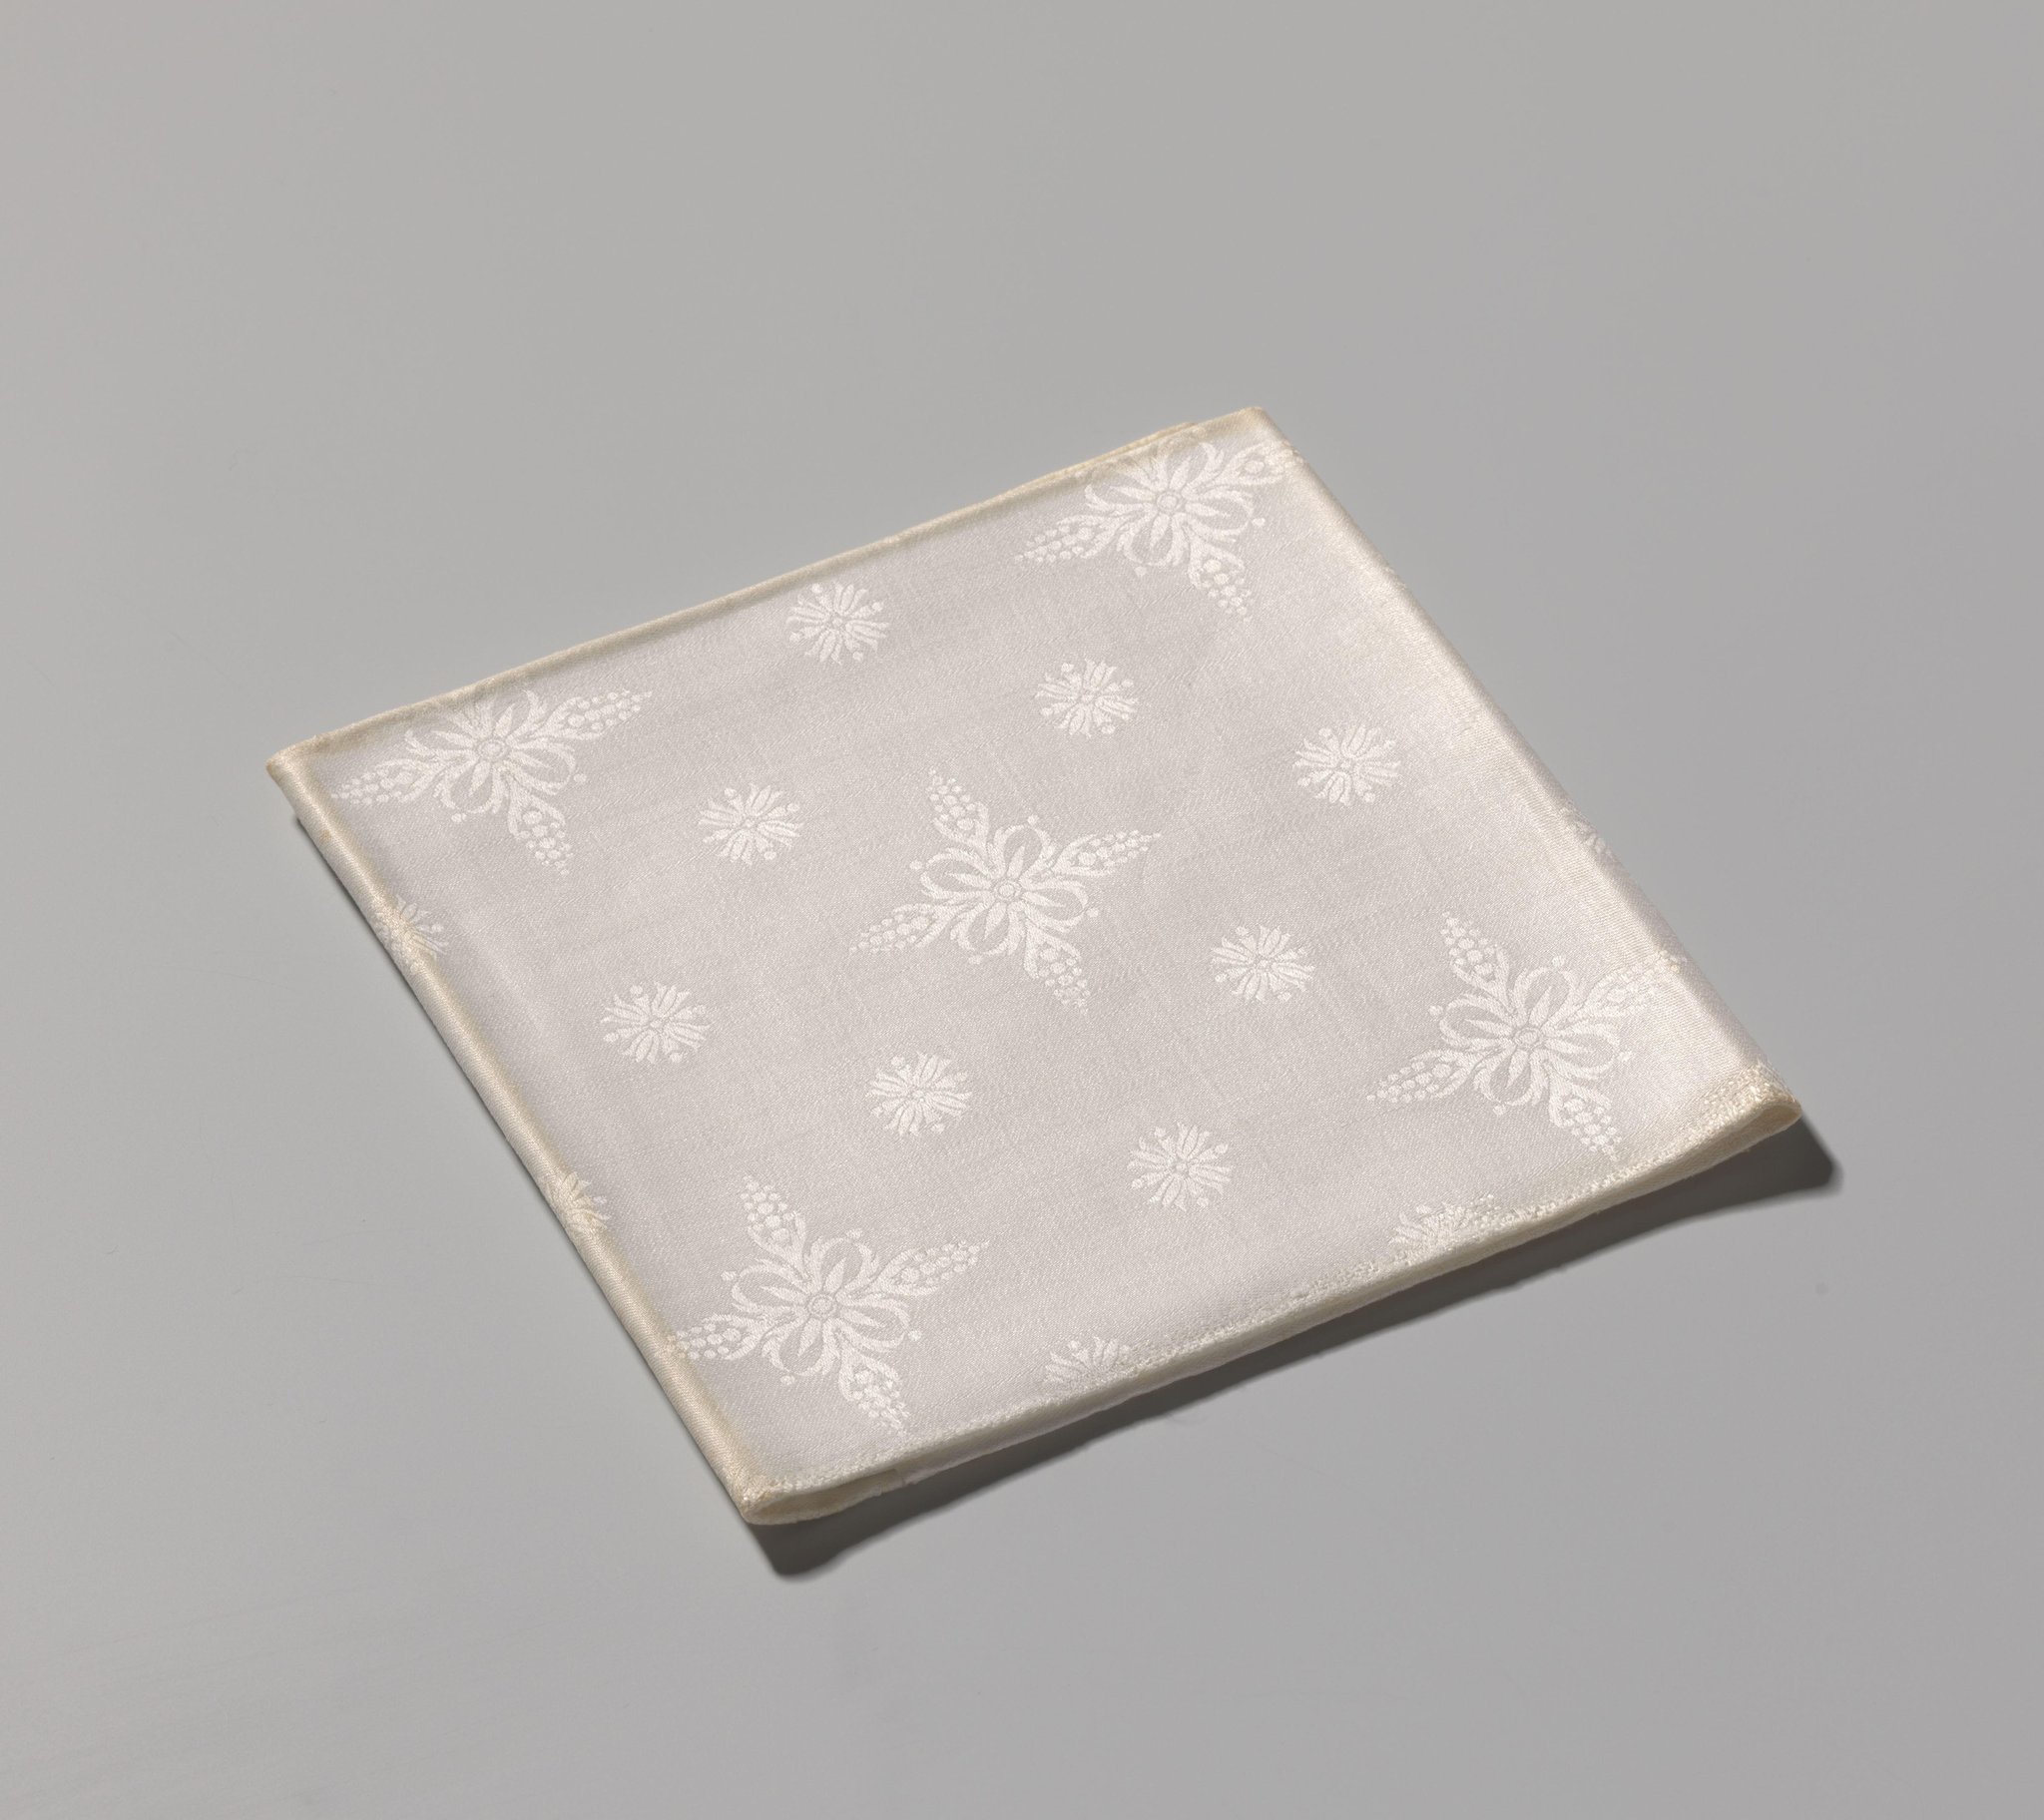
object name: napkin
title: Servet van wit linnendamast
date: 1910-1930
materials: linen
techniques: damask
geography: northern netherlands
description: Wit linnendamasten servet met een patroon van guirlandes en vazen, merk B 24.